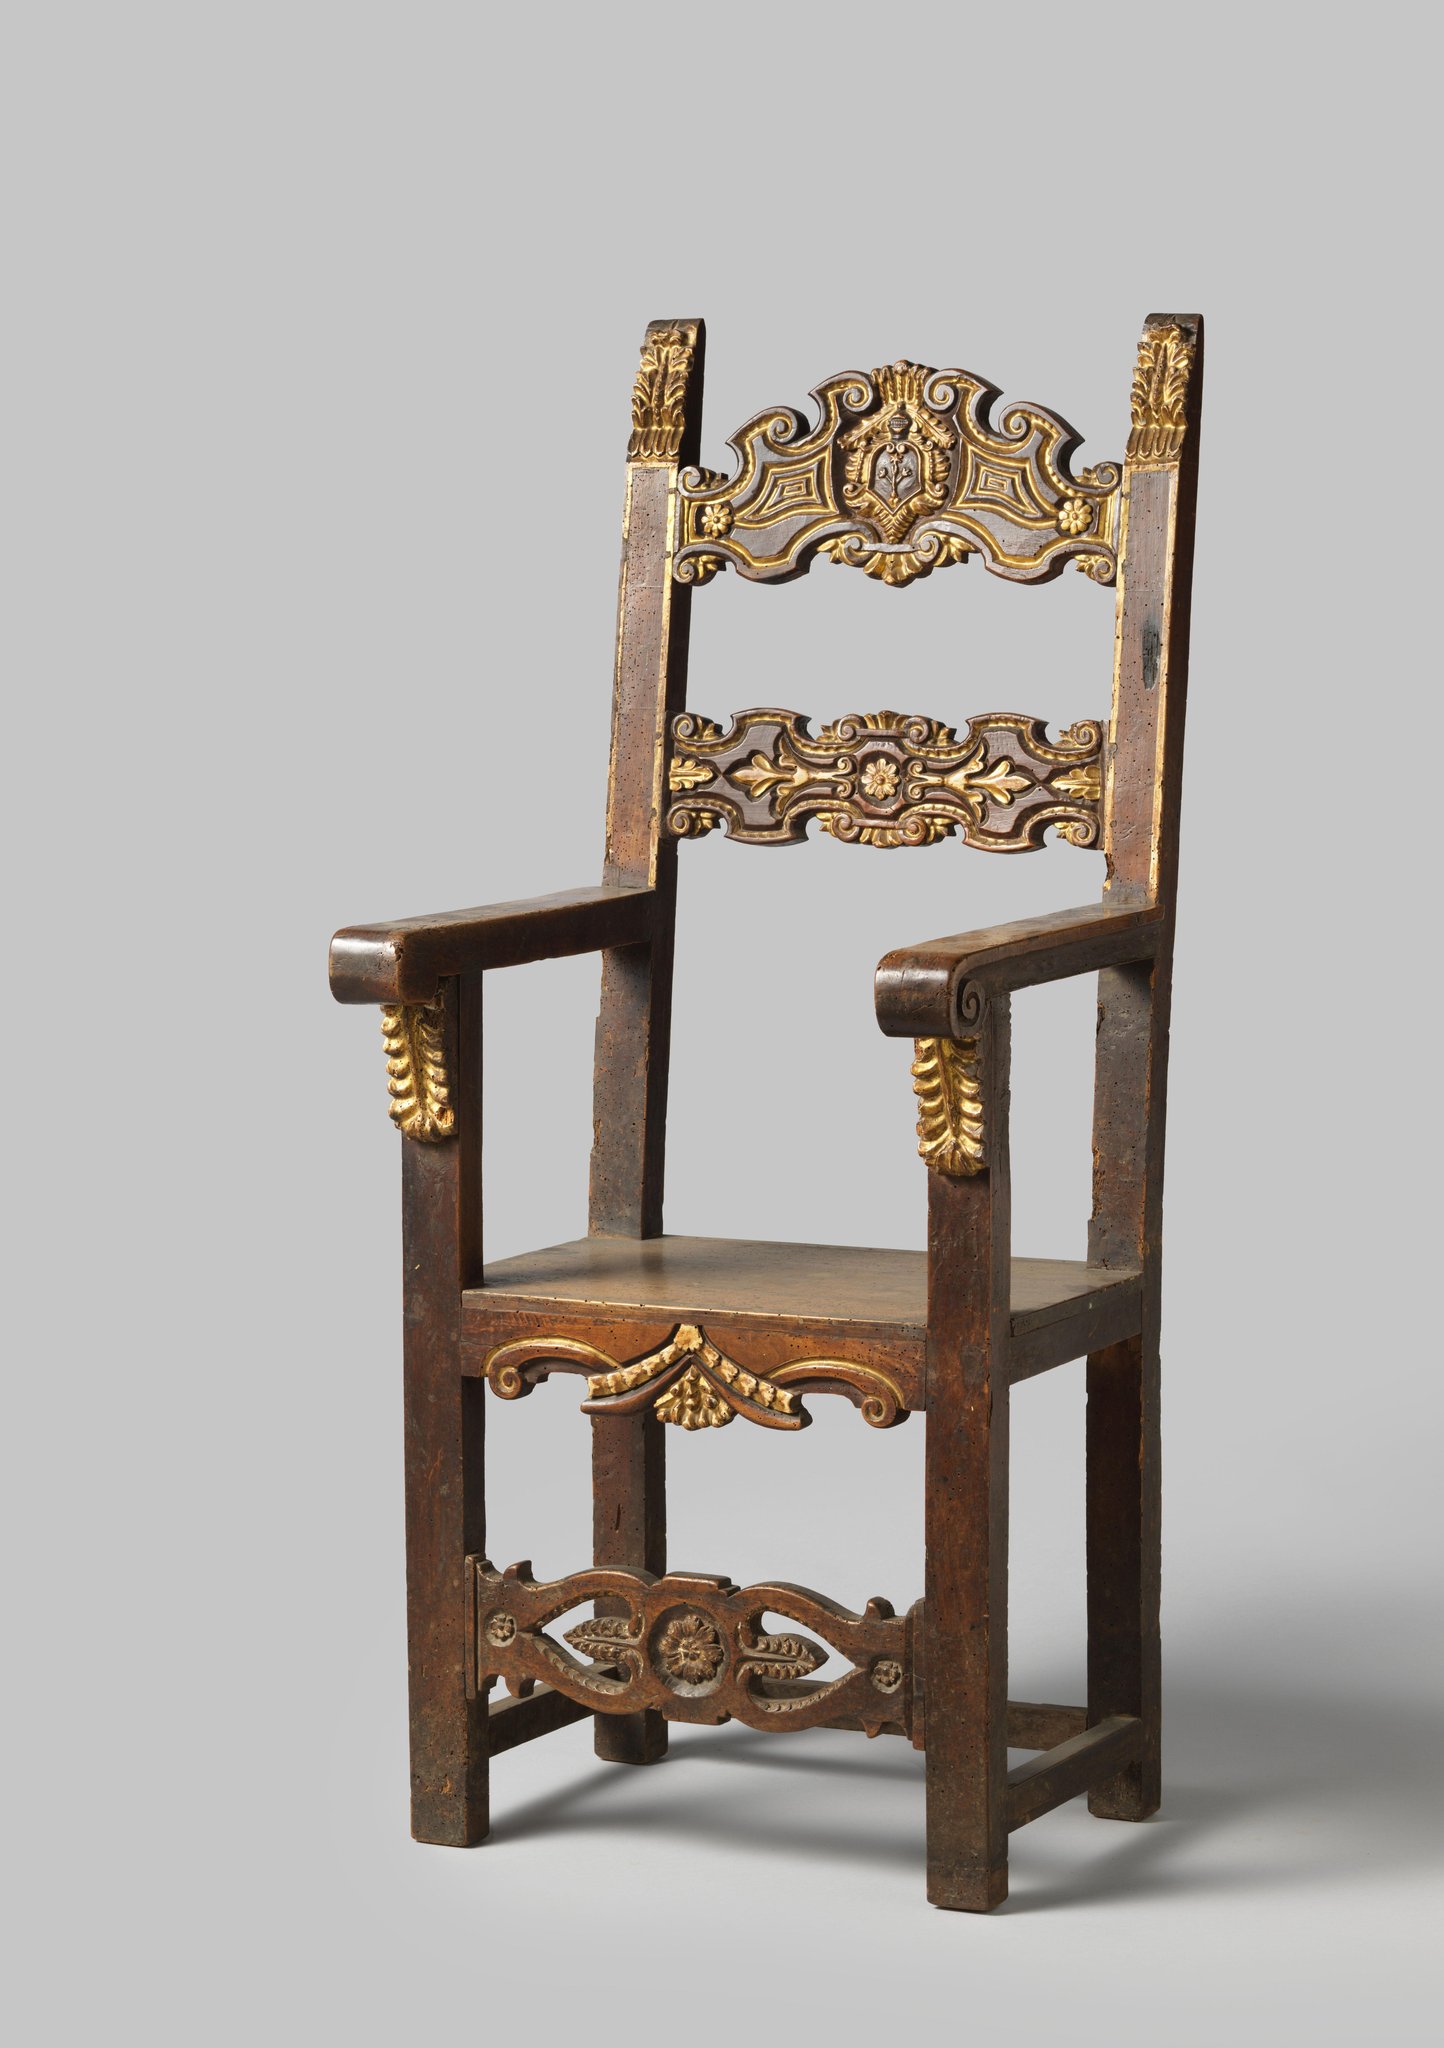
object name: armchair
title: Armstoel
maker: Anonymous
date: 1500-1600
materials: wood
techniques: gilding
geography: italy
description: Armstoel van notenhout, gedeeltelijk verguld. De voorpoten eindigen als stutten, die bovenaan met bladconsoles versierd zijn, en die de armleggers, eindigend in voluten, steunen. De uitgezaagde voorsport, voorzitregel en rugsporten zijn versierd met ondermeer gestoken bladmotieven, rozetten en voluten. De rugstijlen, bekroond met bladmotieven, hellen achterwaarts. De bovensport van de rug draagt een wapenschild met bloemen, kogels en een ster. De poten zijn vierkant. Zie tevens BK-16646-a, b en d.